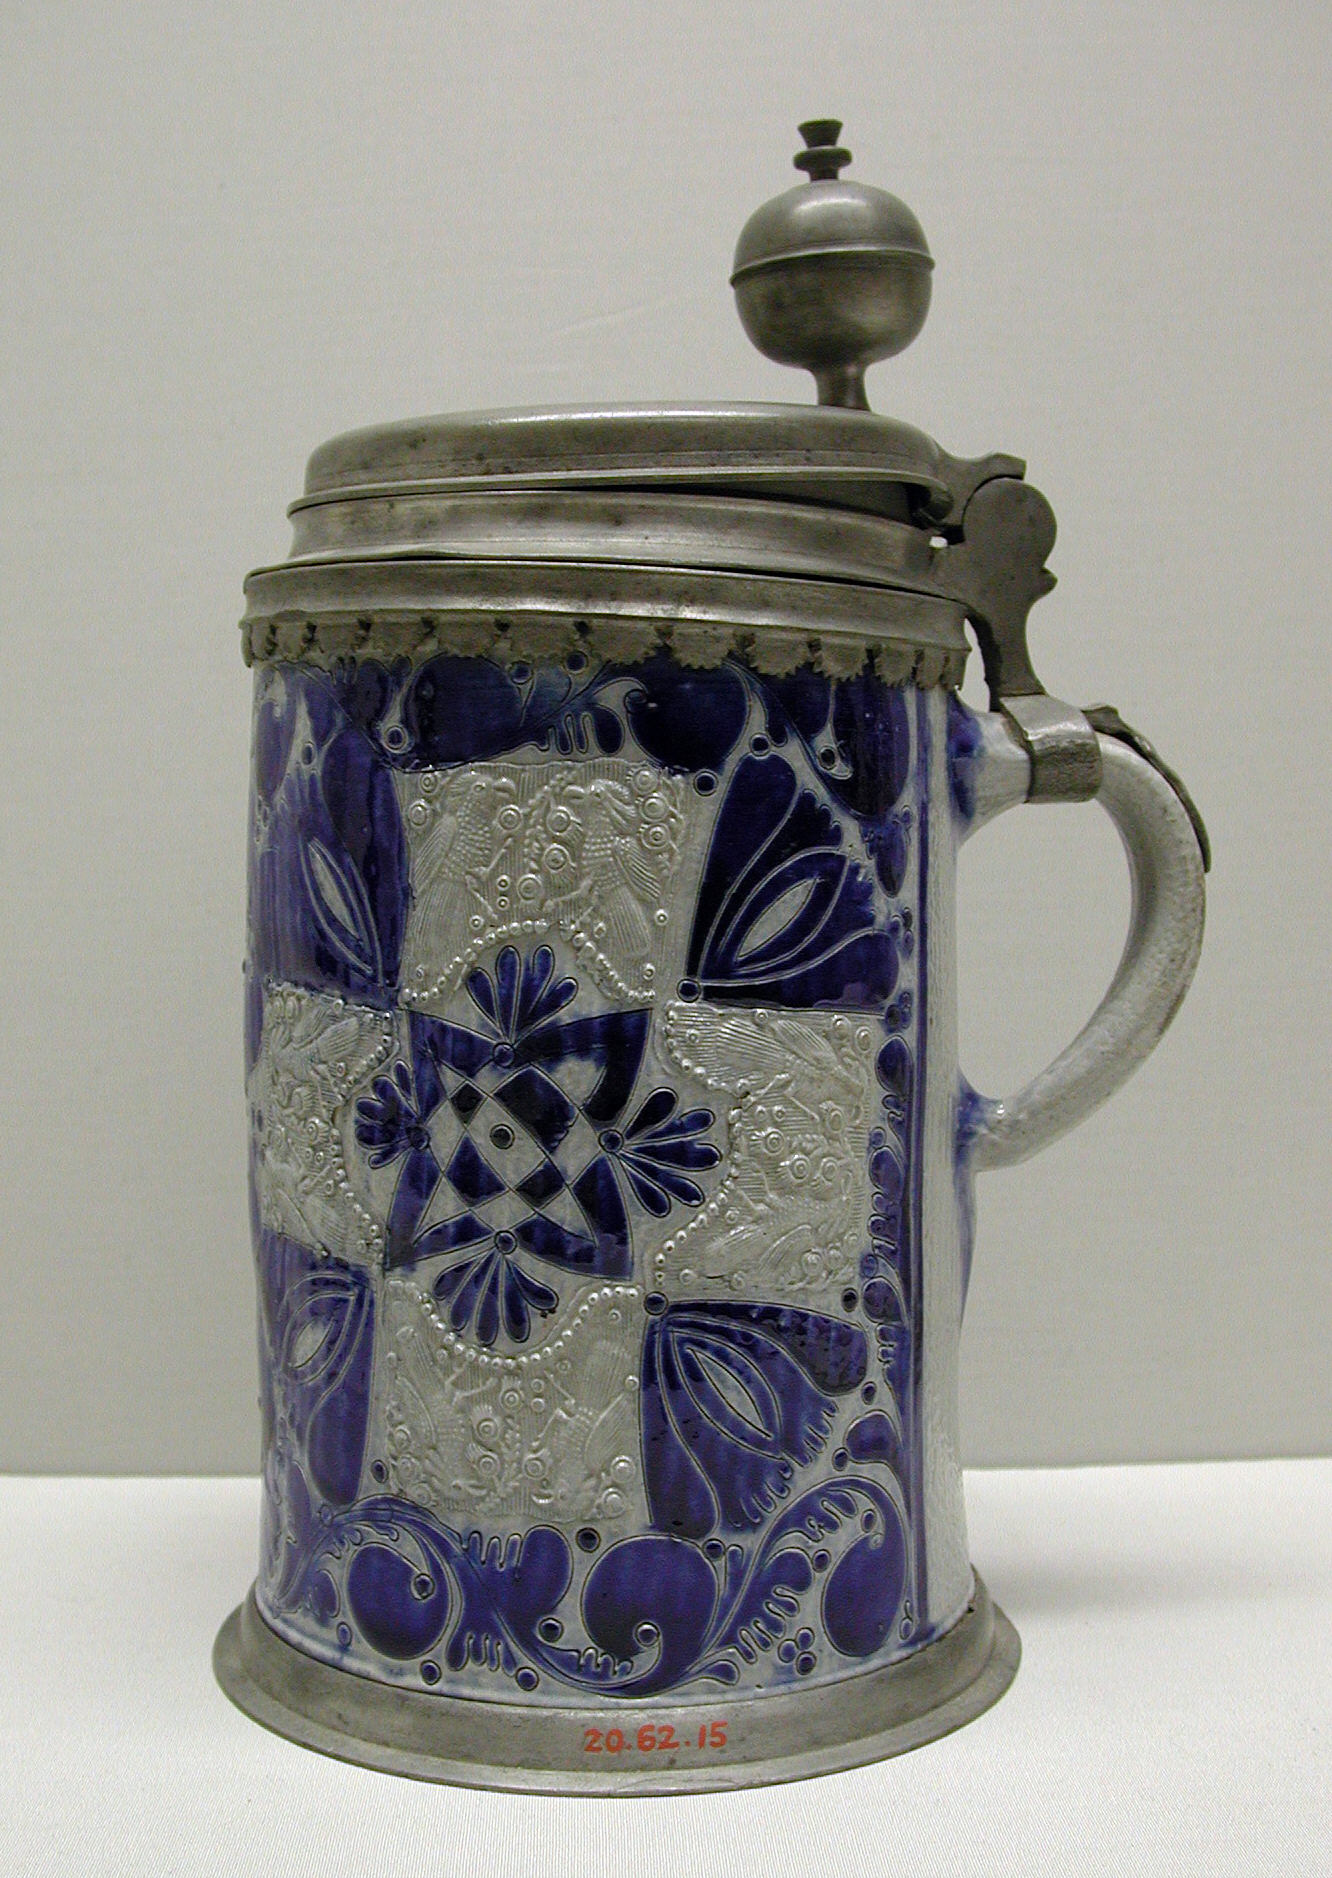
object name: tankard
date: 1701-1900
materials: pewter, stoneware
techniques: salt glaze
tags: birds